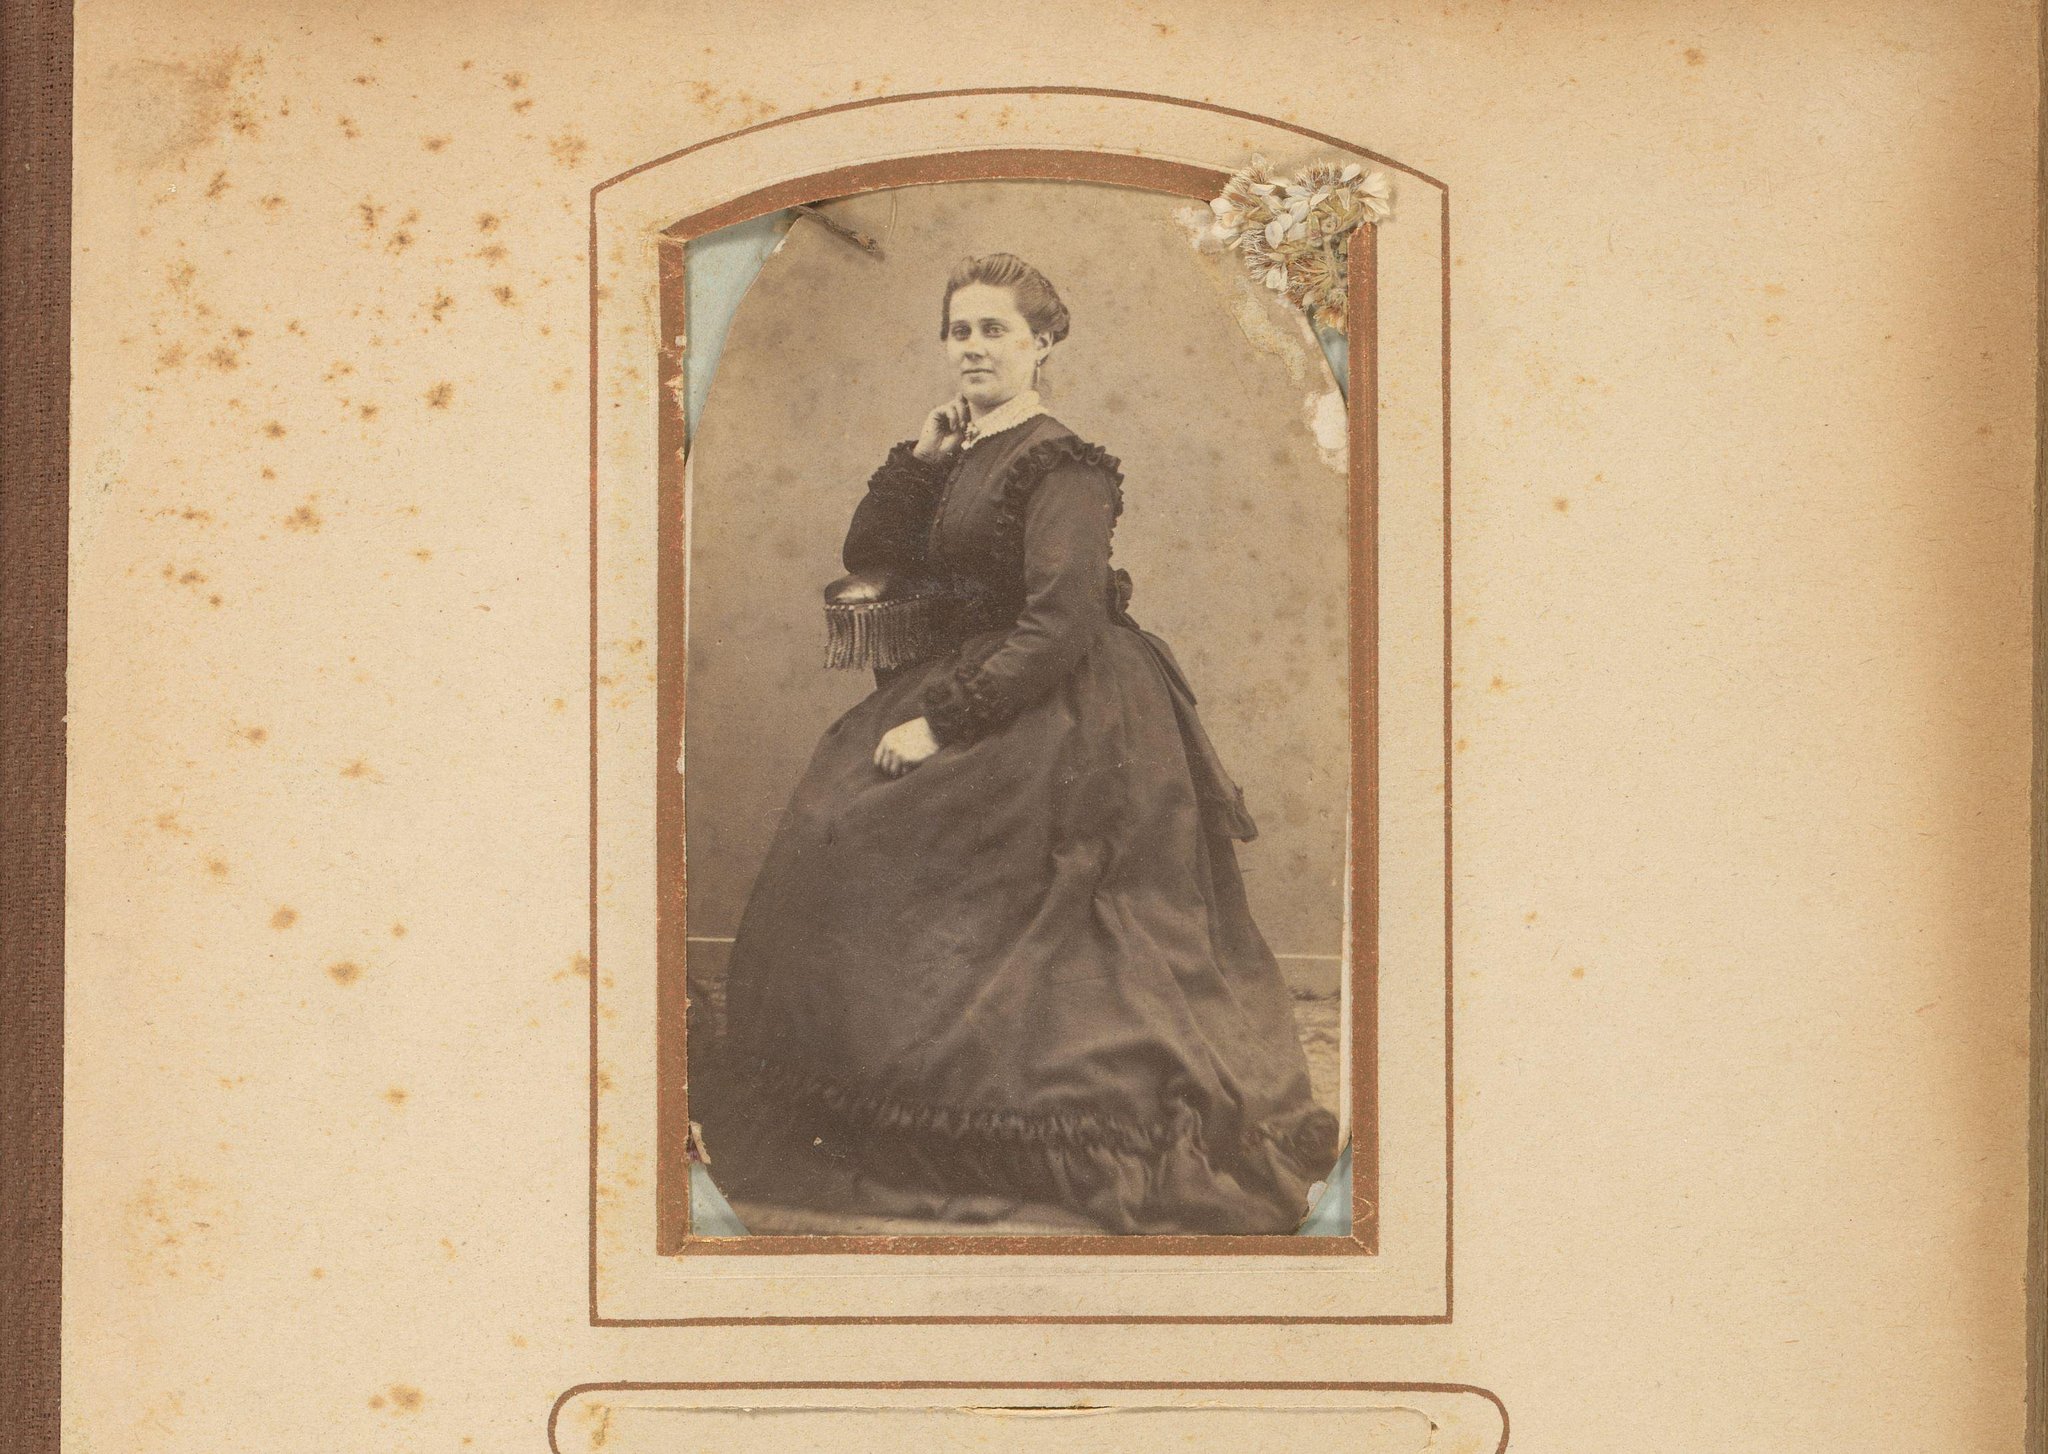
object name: album leaf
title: Portret van een vrouw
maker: Anonymous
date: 1860-1900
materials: cardboard, photographic support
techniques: albumen print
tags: historical persons - bb - woman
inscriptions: annotation: ‘A Voget (...)’